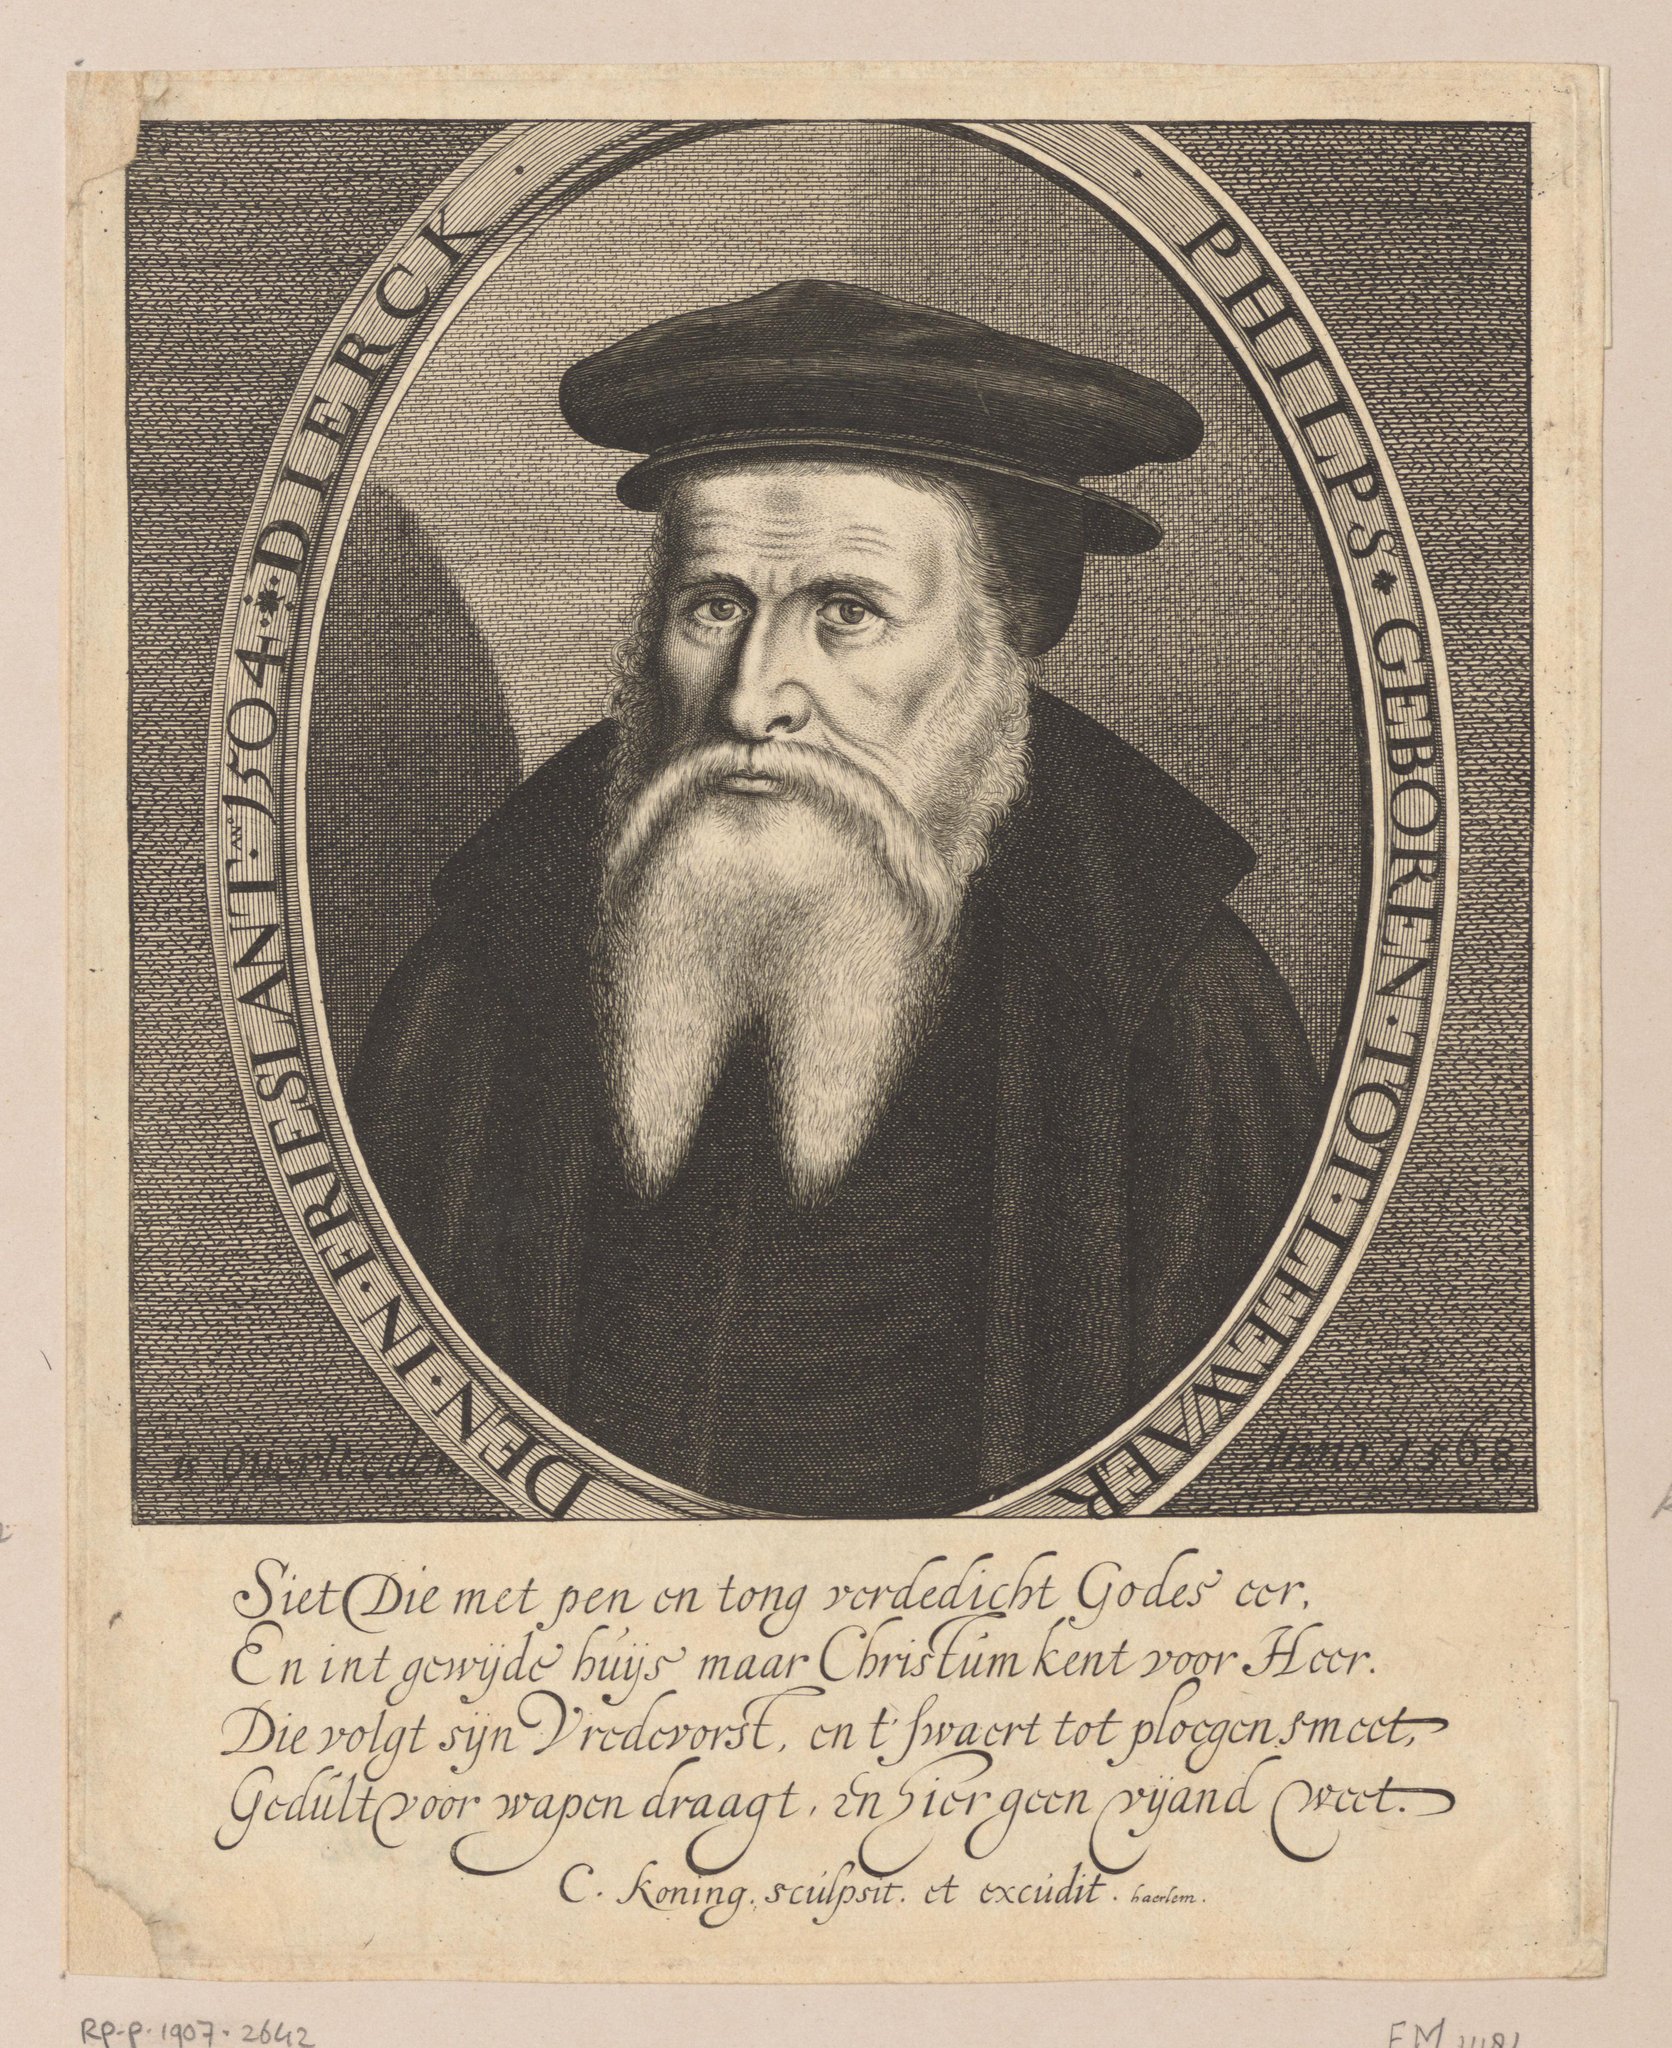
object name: print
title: Portret van Dirk Philips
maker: cornelis koning (?-1671)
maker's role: print maker, publisher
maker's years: -1671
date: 1608-1671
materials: paper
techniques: engraving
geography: haarlem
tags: adult man, historical persons, beard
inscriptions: collector's mark: Lugt 2228, collector's mark: Lugt 1731, inscription: ‘P. Mariette 1674.’ Lugt 1790